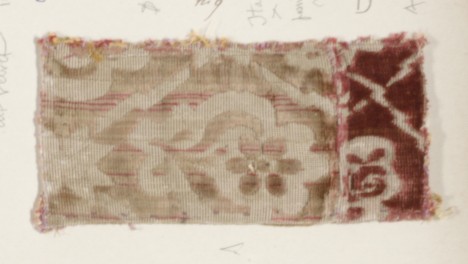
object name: fragment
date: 1701-1800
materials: metal thread, silk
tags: flowers